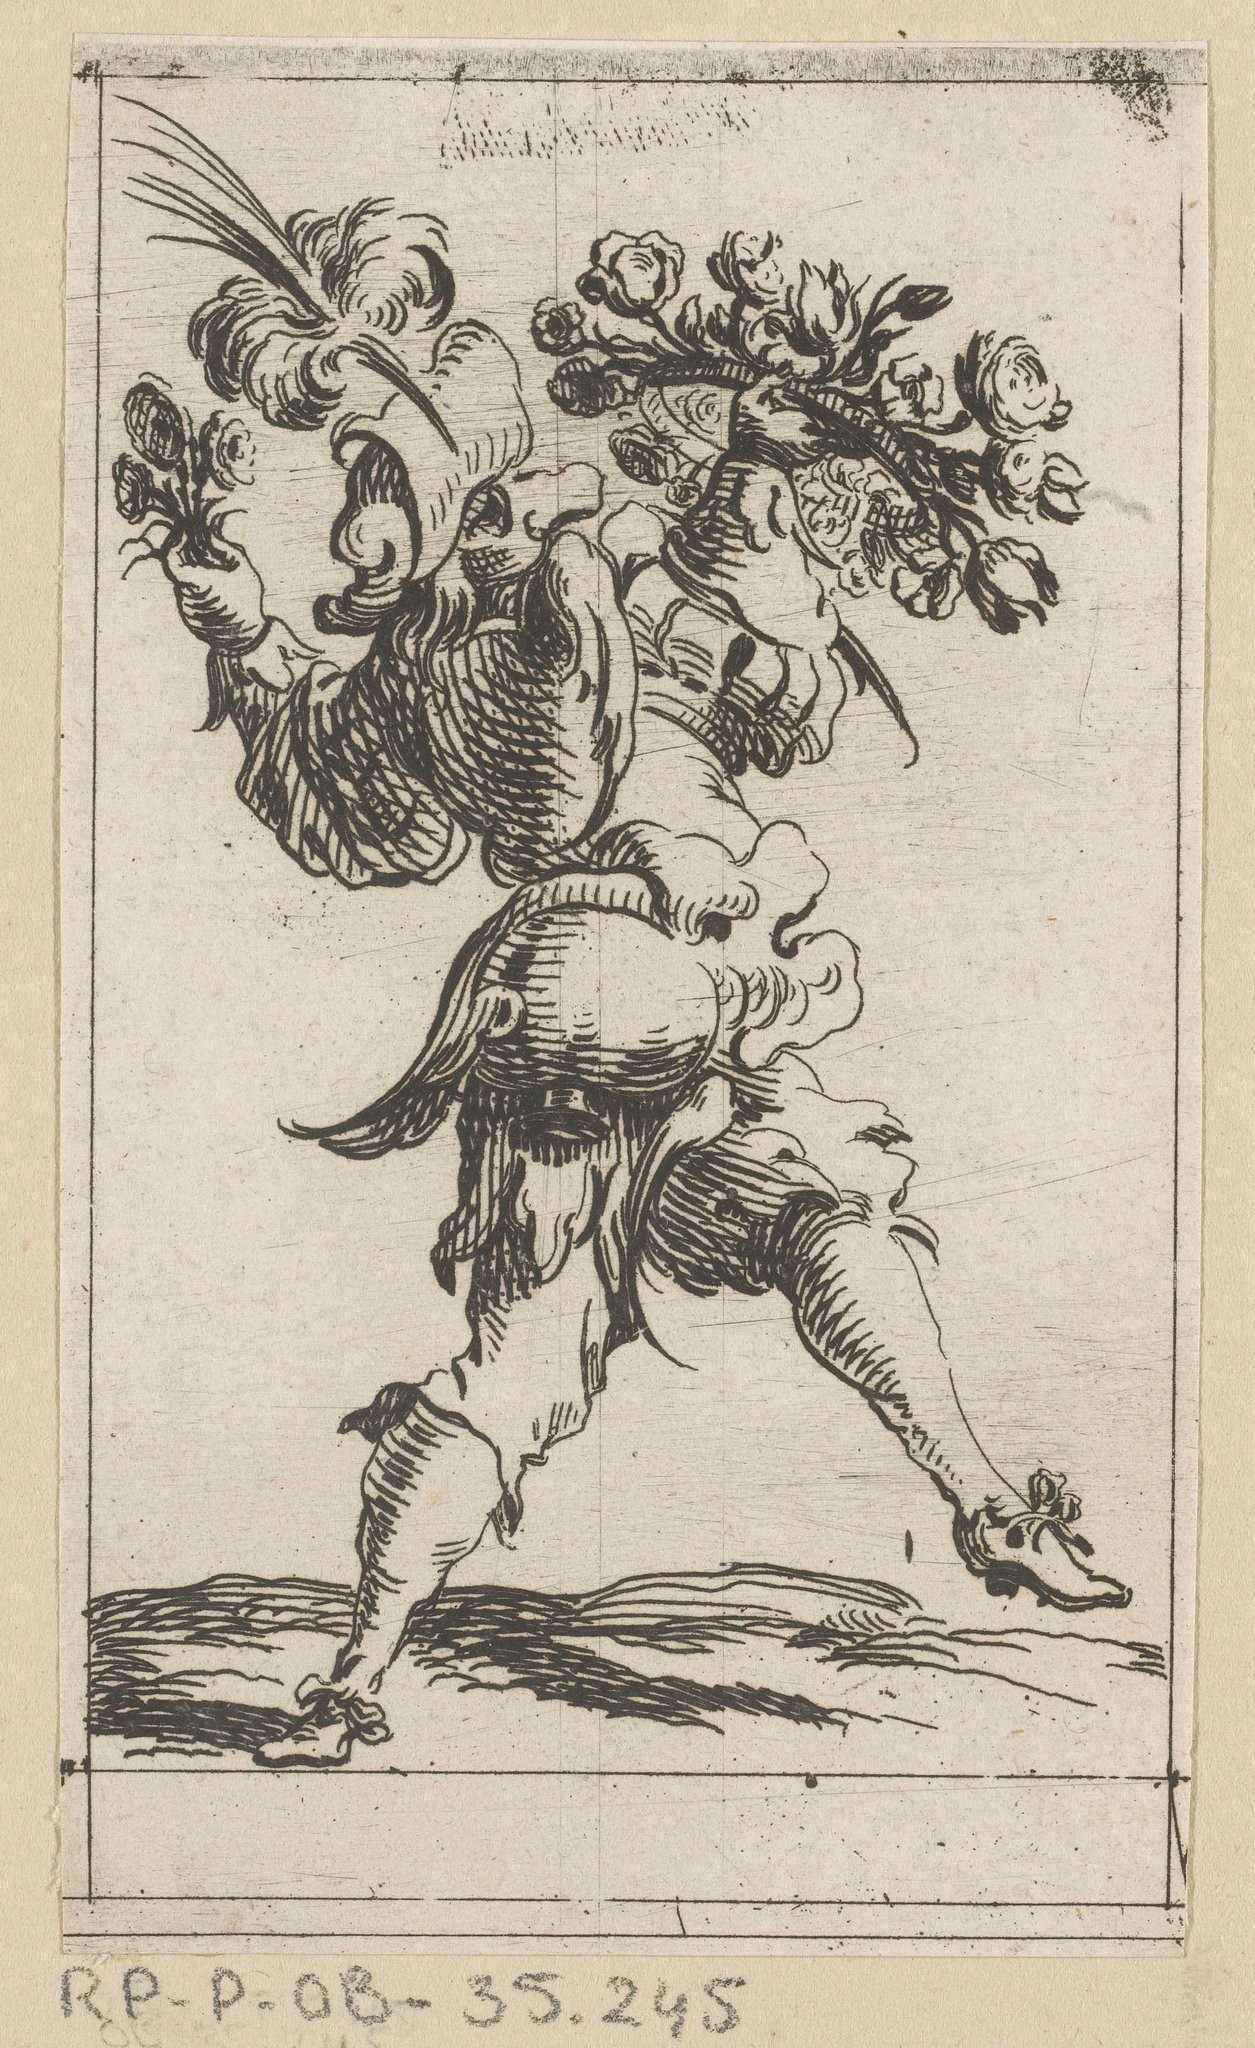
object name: print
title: Mei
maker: denis boutemie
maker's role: print maker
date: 1633-1643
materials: paper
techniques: etching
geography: paris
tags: may; 'maggio' (ripa)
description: Personificatie van de maand mei. Een grotesk figuur met een pluimenhoed op zijn hoofd en bloemen in zijn handen.